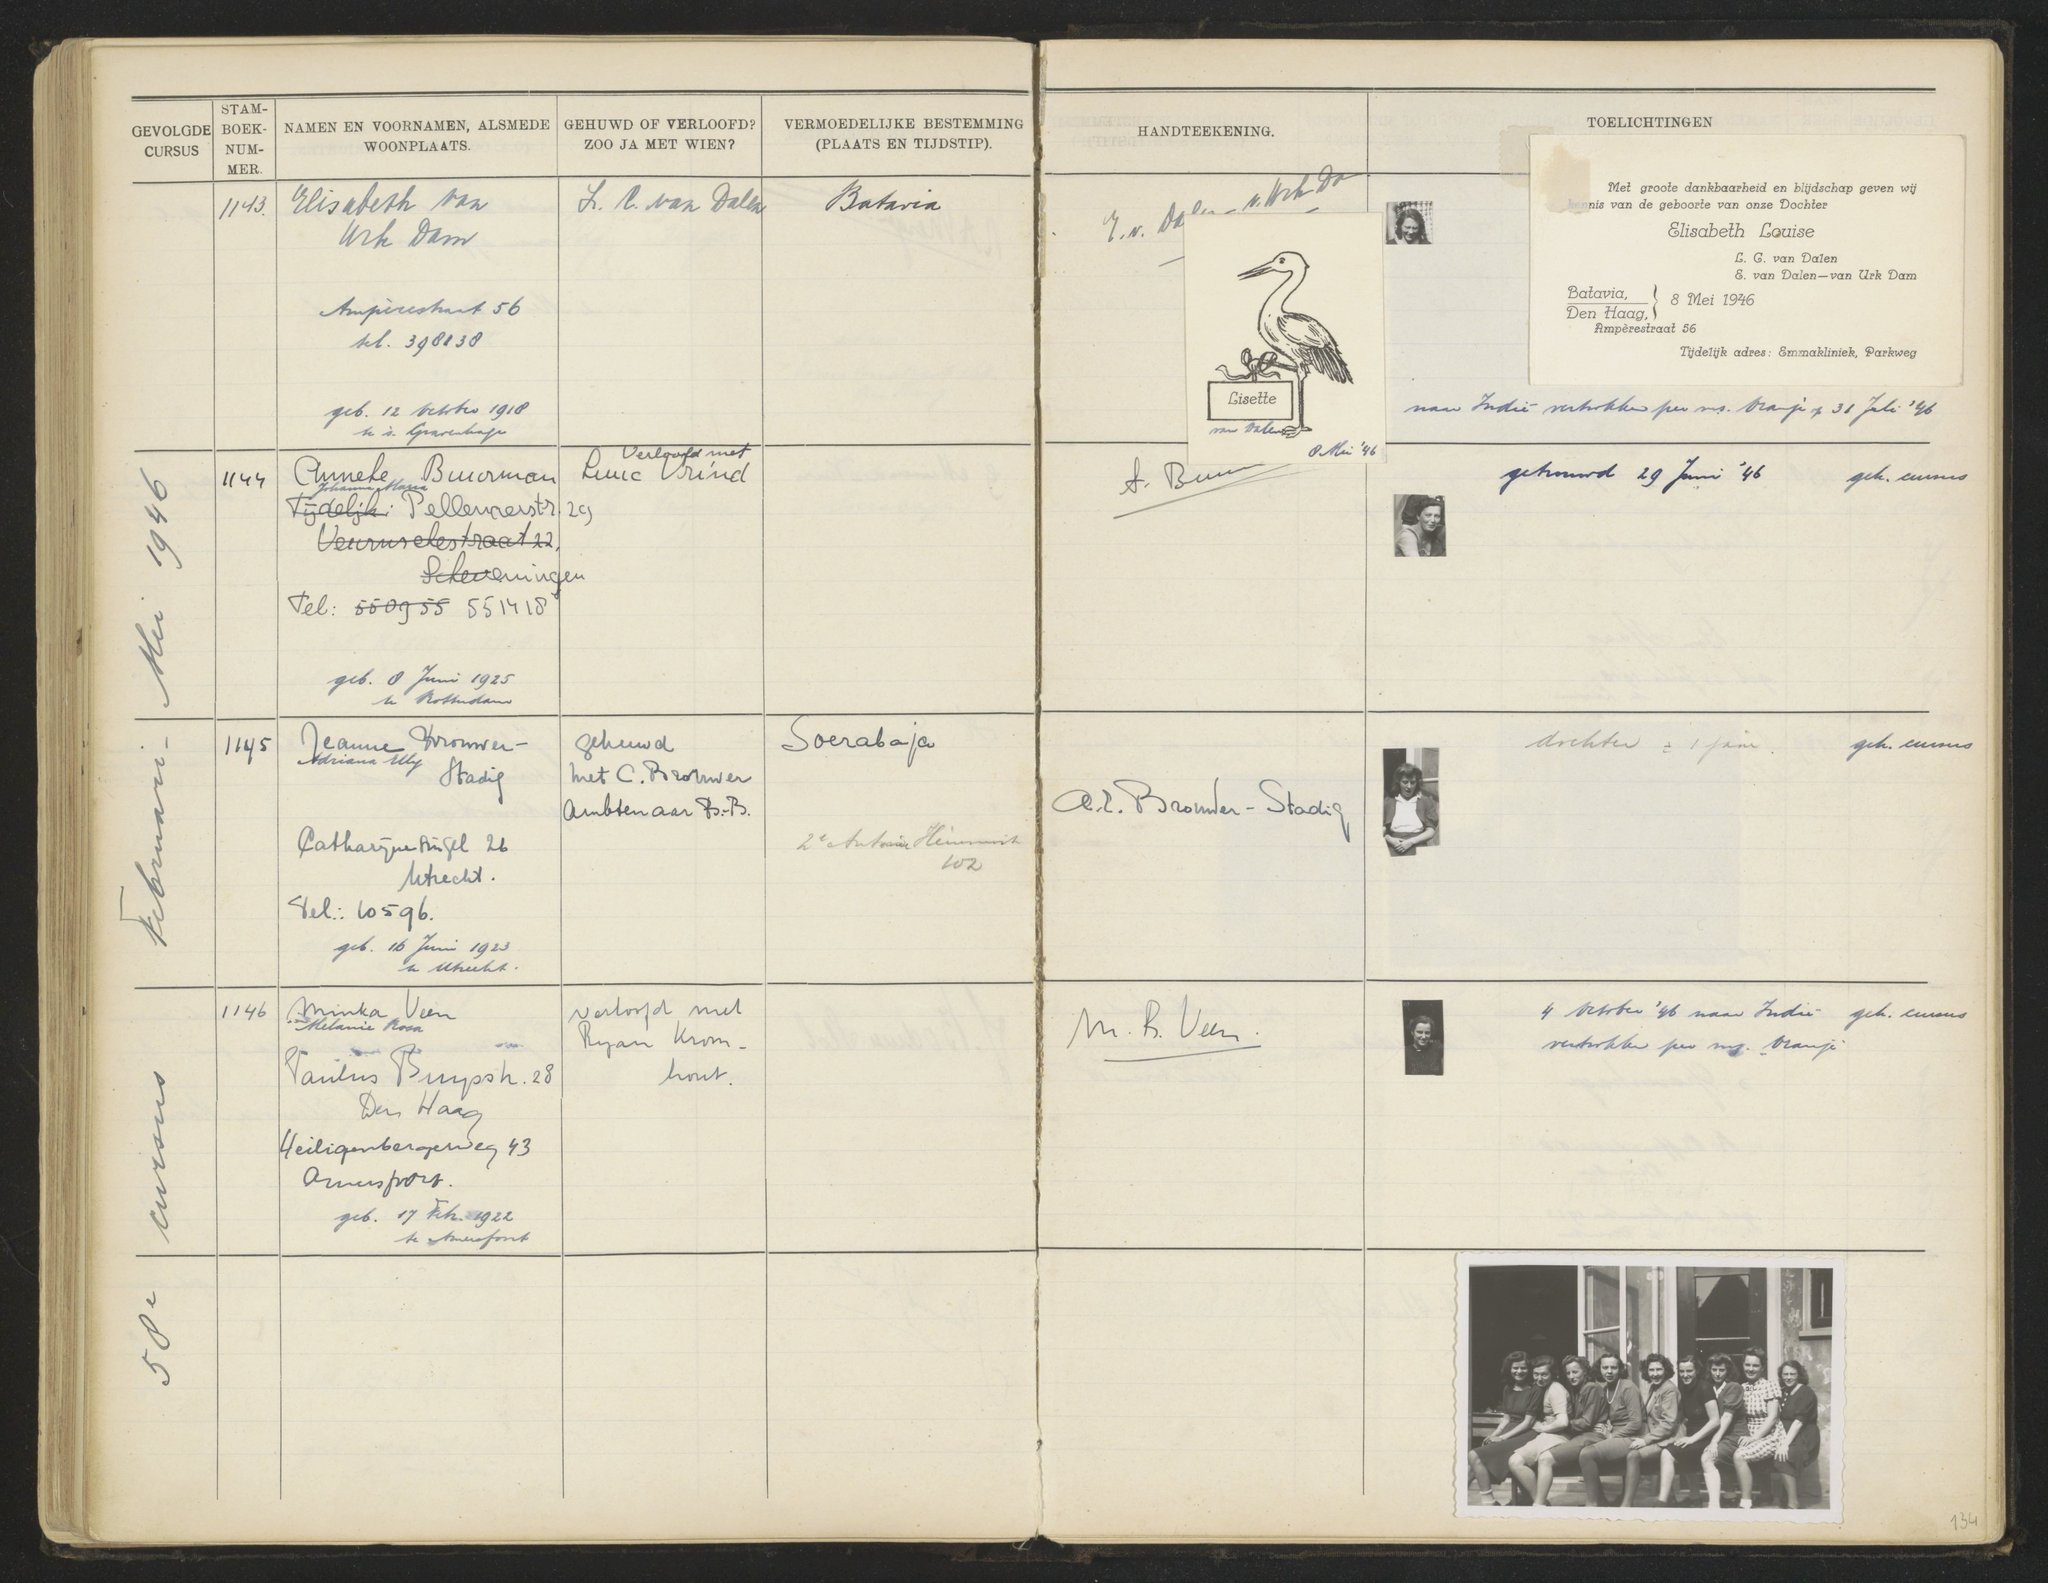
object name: album leaf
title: Blad 134 uit Stamboek van de leerlingen der Koloniale School voor Meisjes en Vrouwen te 's-Gravenhage deel II (1930-1949)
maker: Anonymous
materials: paper, photographic support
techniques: photography, printing, writing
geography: the hague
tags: further education (+ pupil), further education, the hague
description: Twee pagina's met gegevens van de deelnemers aan de 58e driemaandelijkse cursus van februari tot mei 1946, stamboeknummers 1143 tot en met 1146. Onderdeel van Stamboek van de leerlingen der Koloniale School voor Meisjes en Vrouwen te 's-Gravenhage deel II (1930-1949).